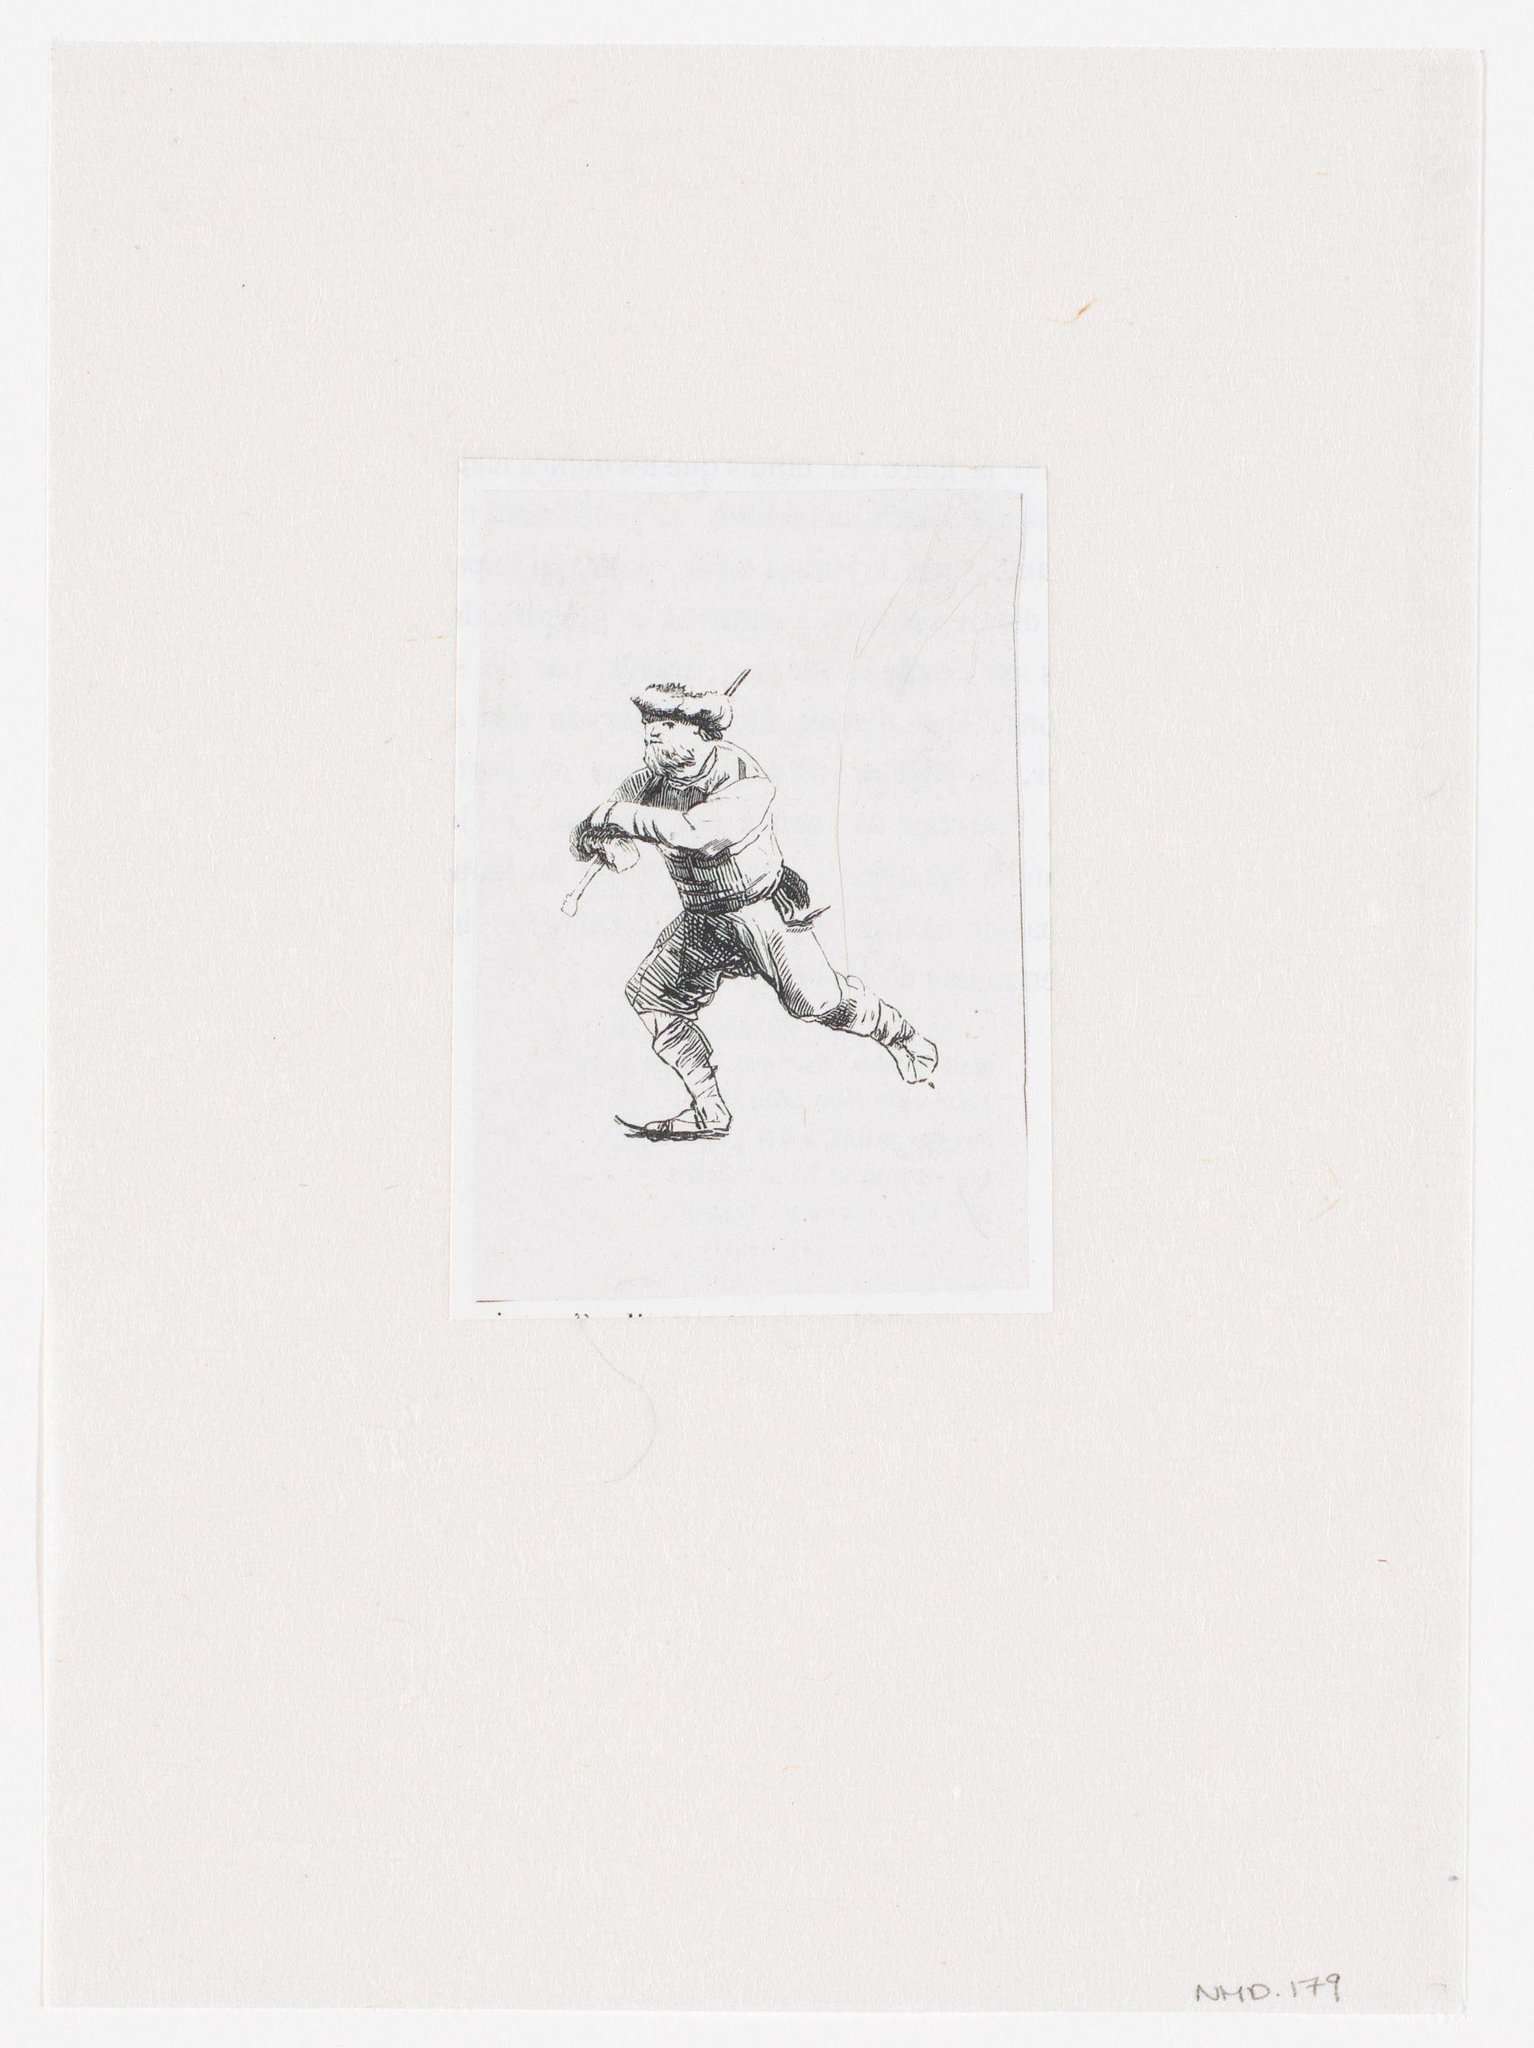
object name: print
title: The skater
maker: léopold flameng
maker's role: print maker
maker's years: 1831-1911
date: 1859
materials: paper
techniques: etching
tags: skates (winter sports)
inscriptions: collector's mark: Lugt 2228, collector's mark: Lugt 2760